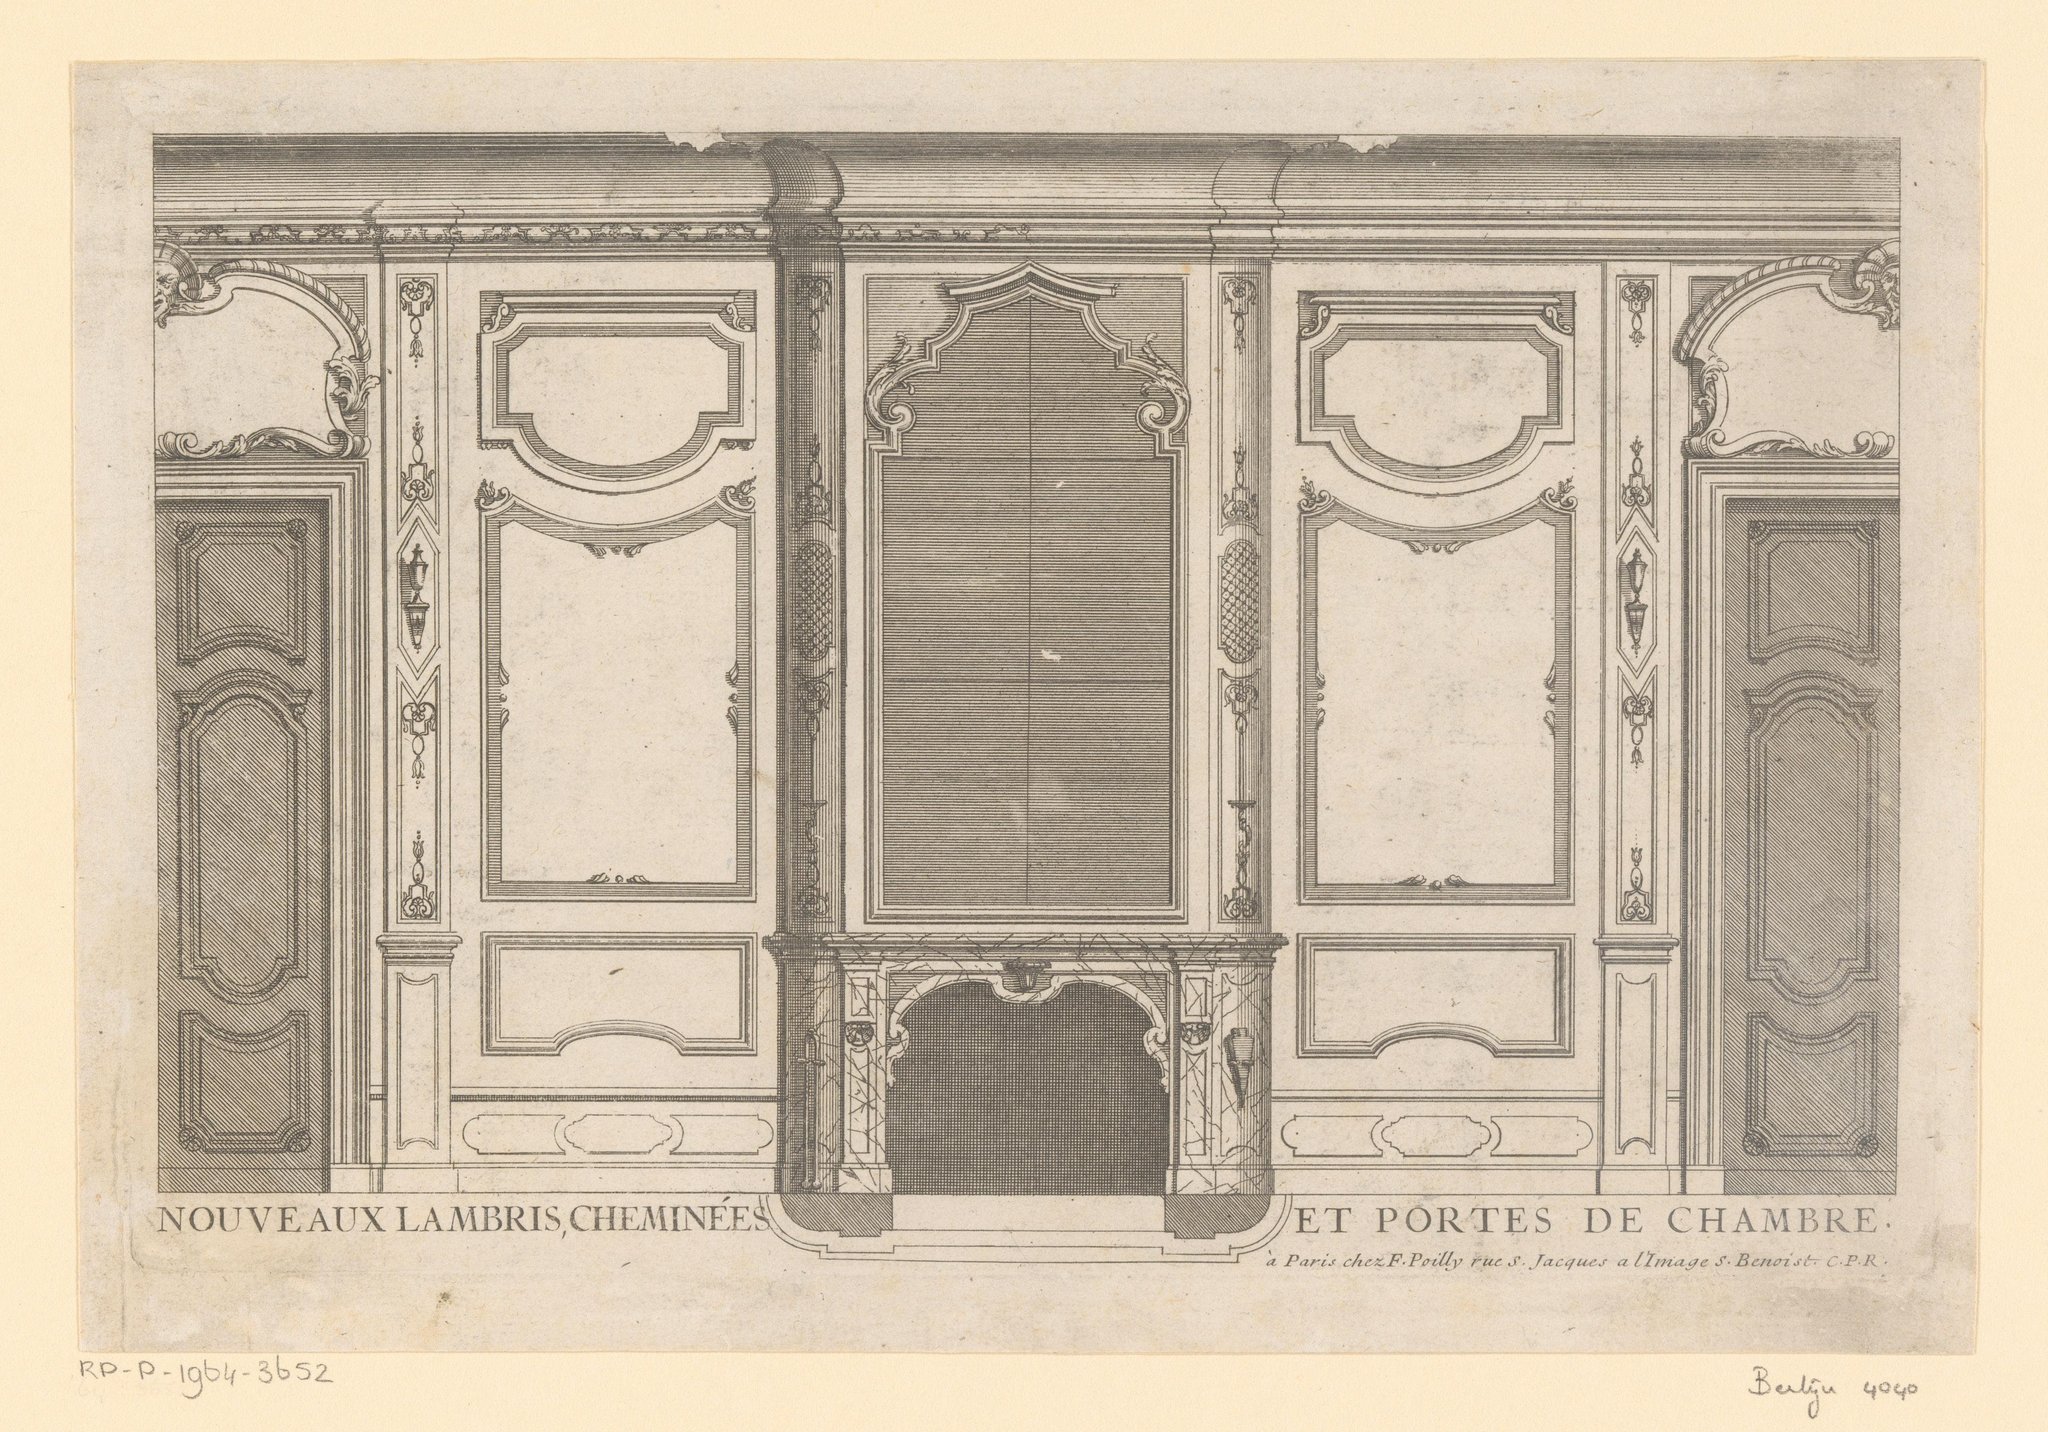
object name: titelprent, frontispice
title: Schouw en deuren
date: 1681-1723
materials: paper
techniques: engraving, etching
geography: paris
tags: open hearth, fire-place, door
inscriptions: collector's mark: Lugt 2228, collector's mark: Lugt 2760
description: Een geornamenteerde schouw geflankeerd door panelen. Links en rechts een deur met rocaille dessus-de-porte.